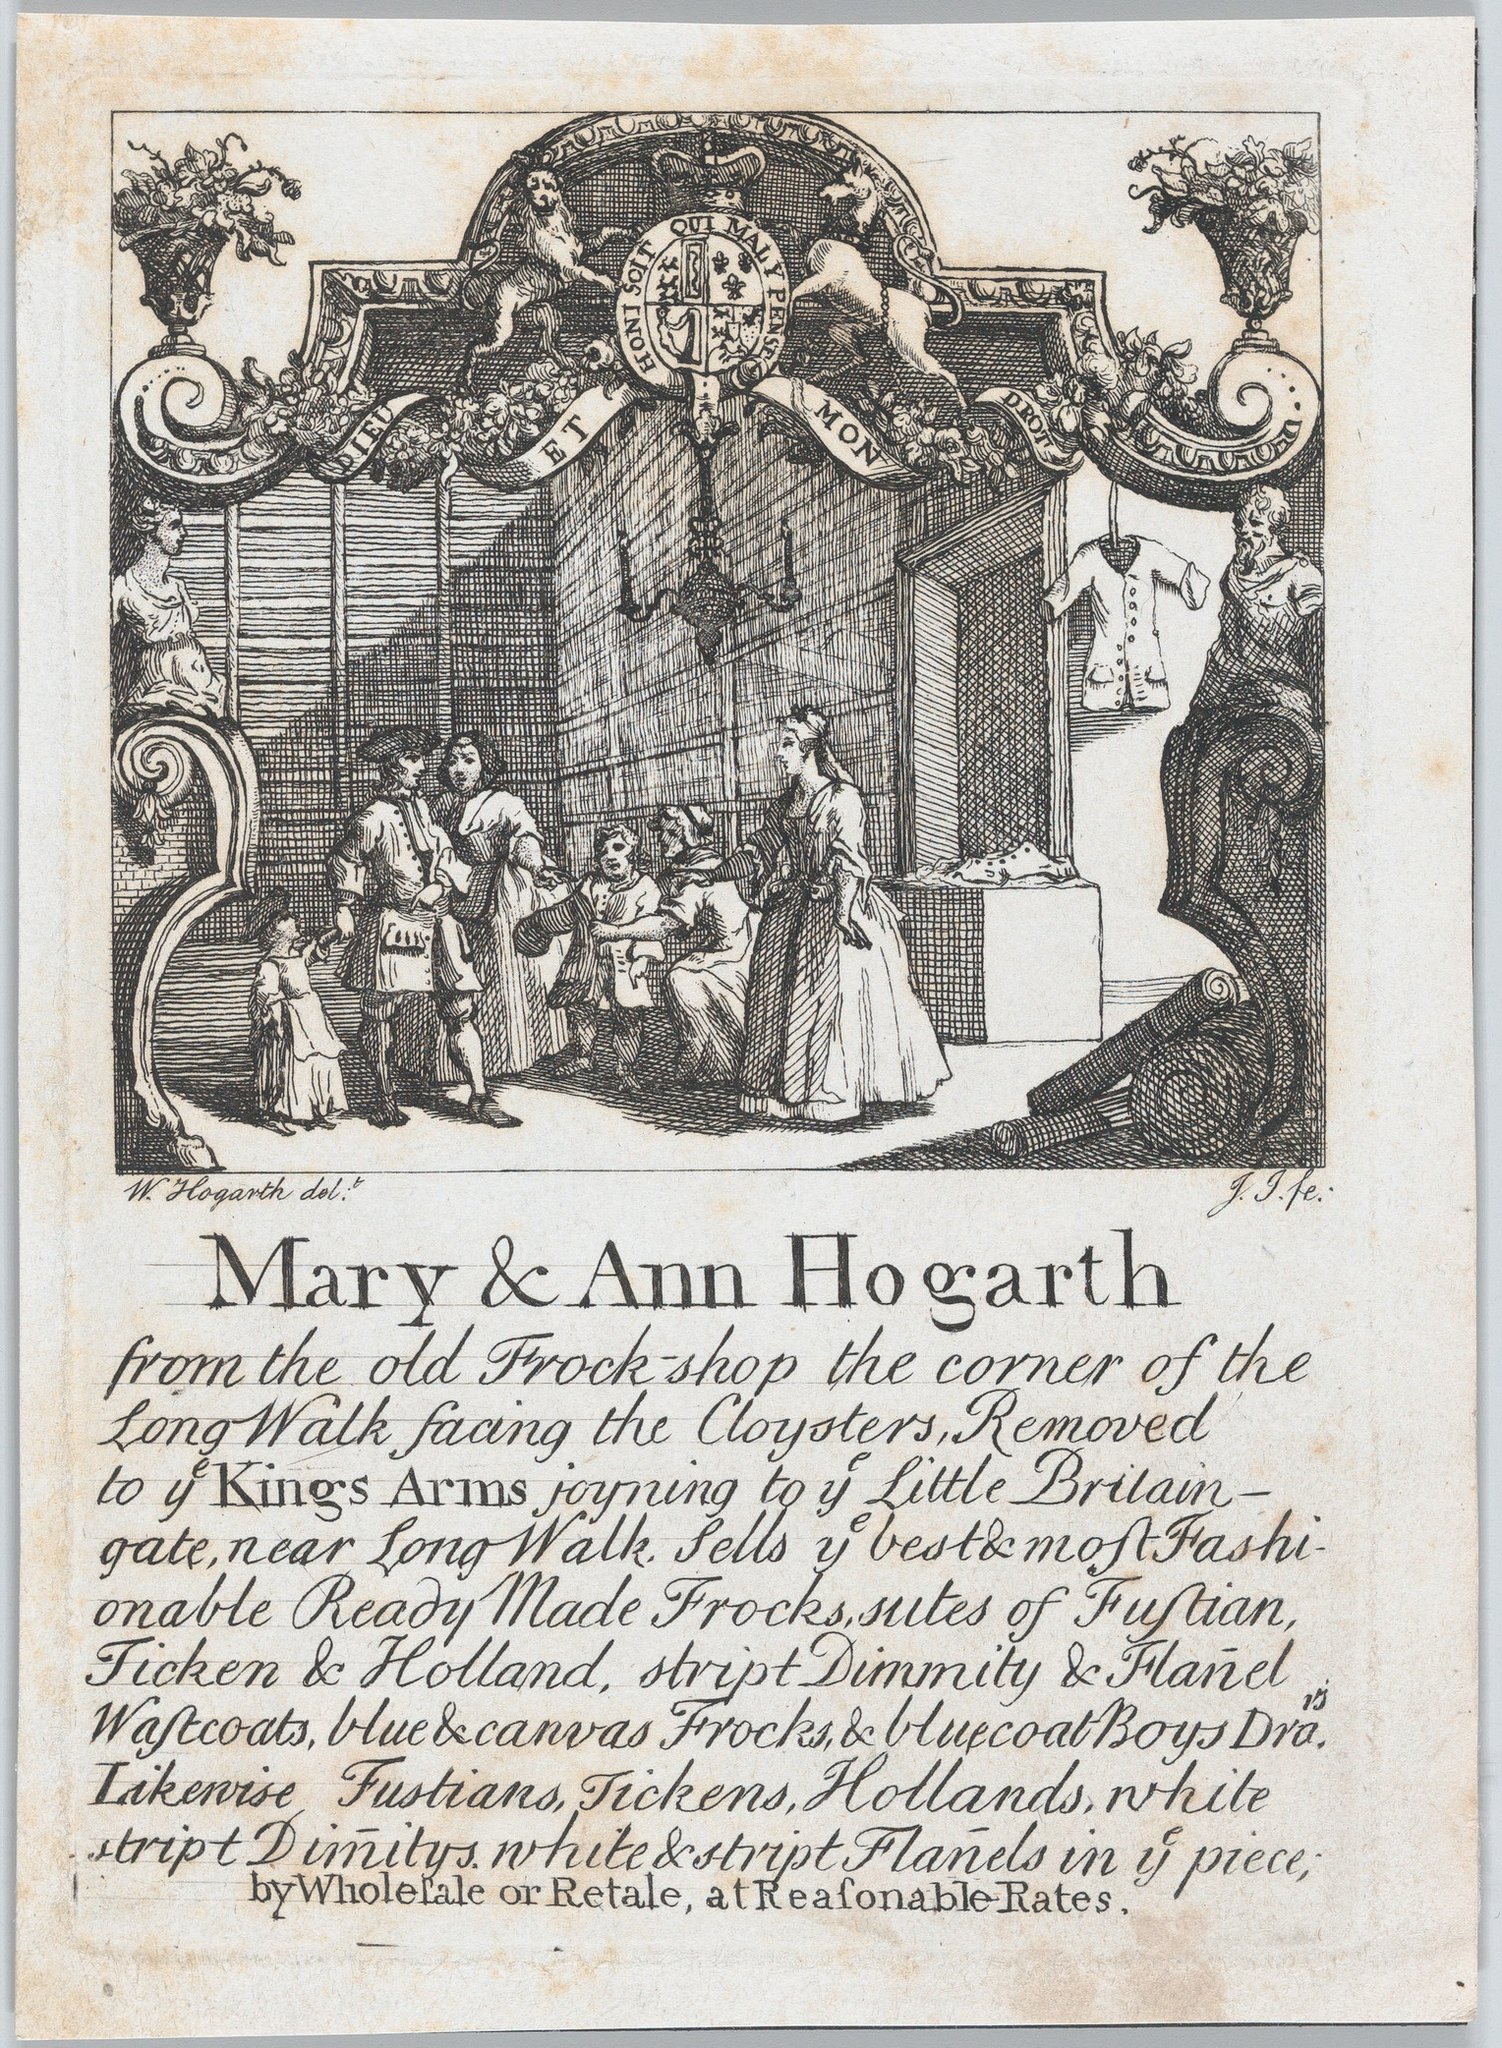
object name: print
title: Trade card of Mary & Ann Hogarth, the old Frock Shop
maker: william hogarth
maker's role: artist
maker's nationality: british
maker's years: 1697-1764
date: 1730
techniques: etching